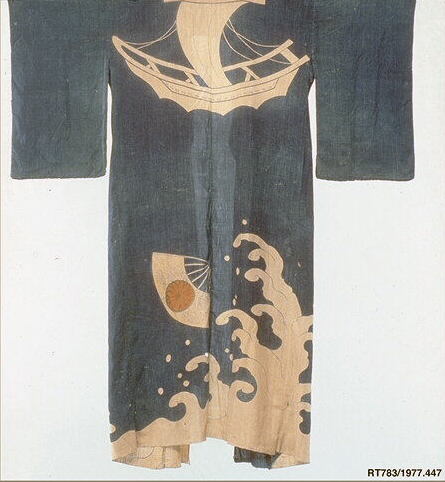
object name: ceremonial robe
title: Fisherman’s Festival Robe (Maiwai) with Waves, Ship, and Fan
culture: japanese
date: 1801-1900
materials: paste, silk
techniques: dyeing, painting, resist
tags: boats